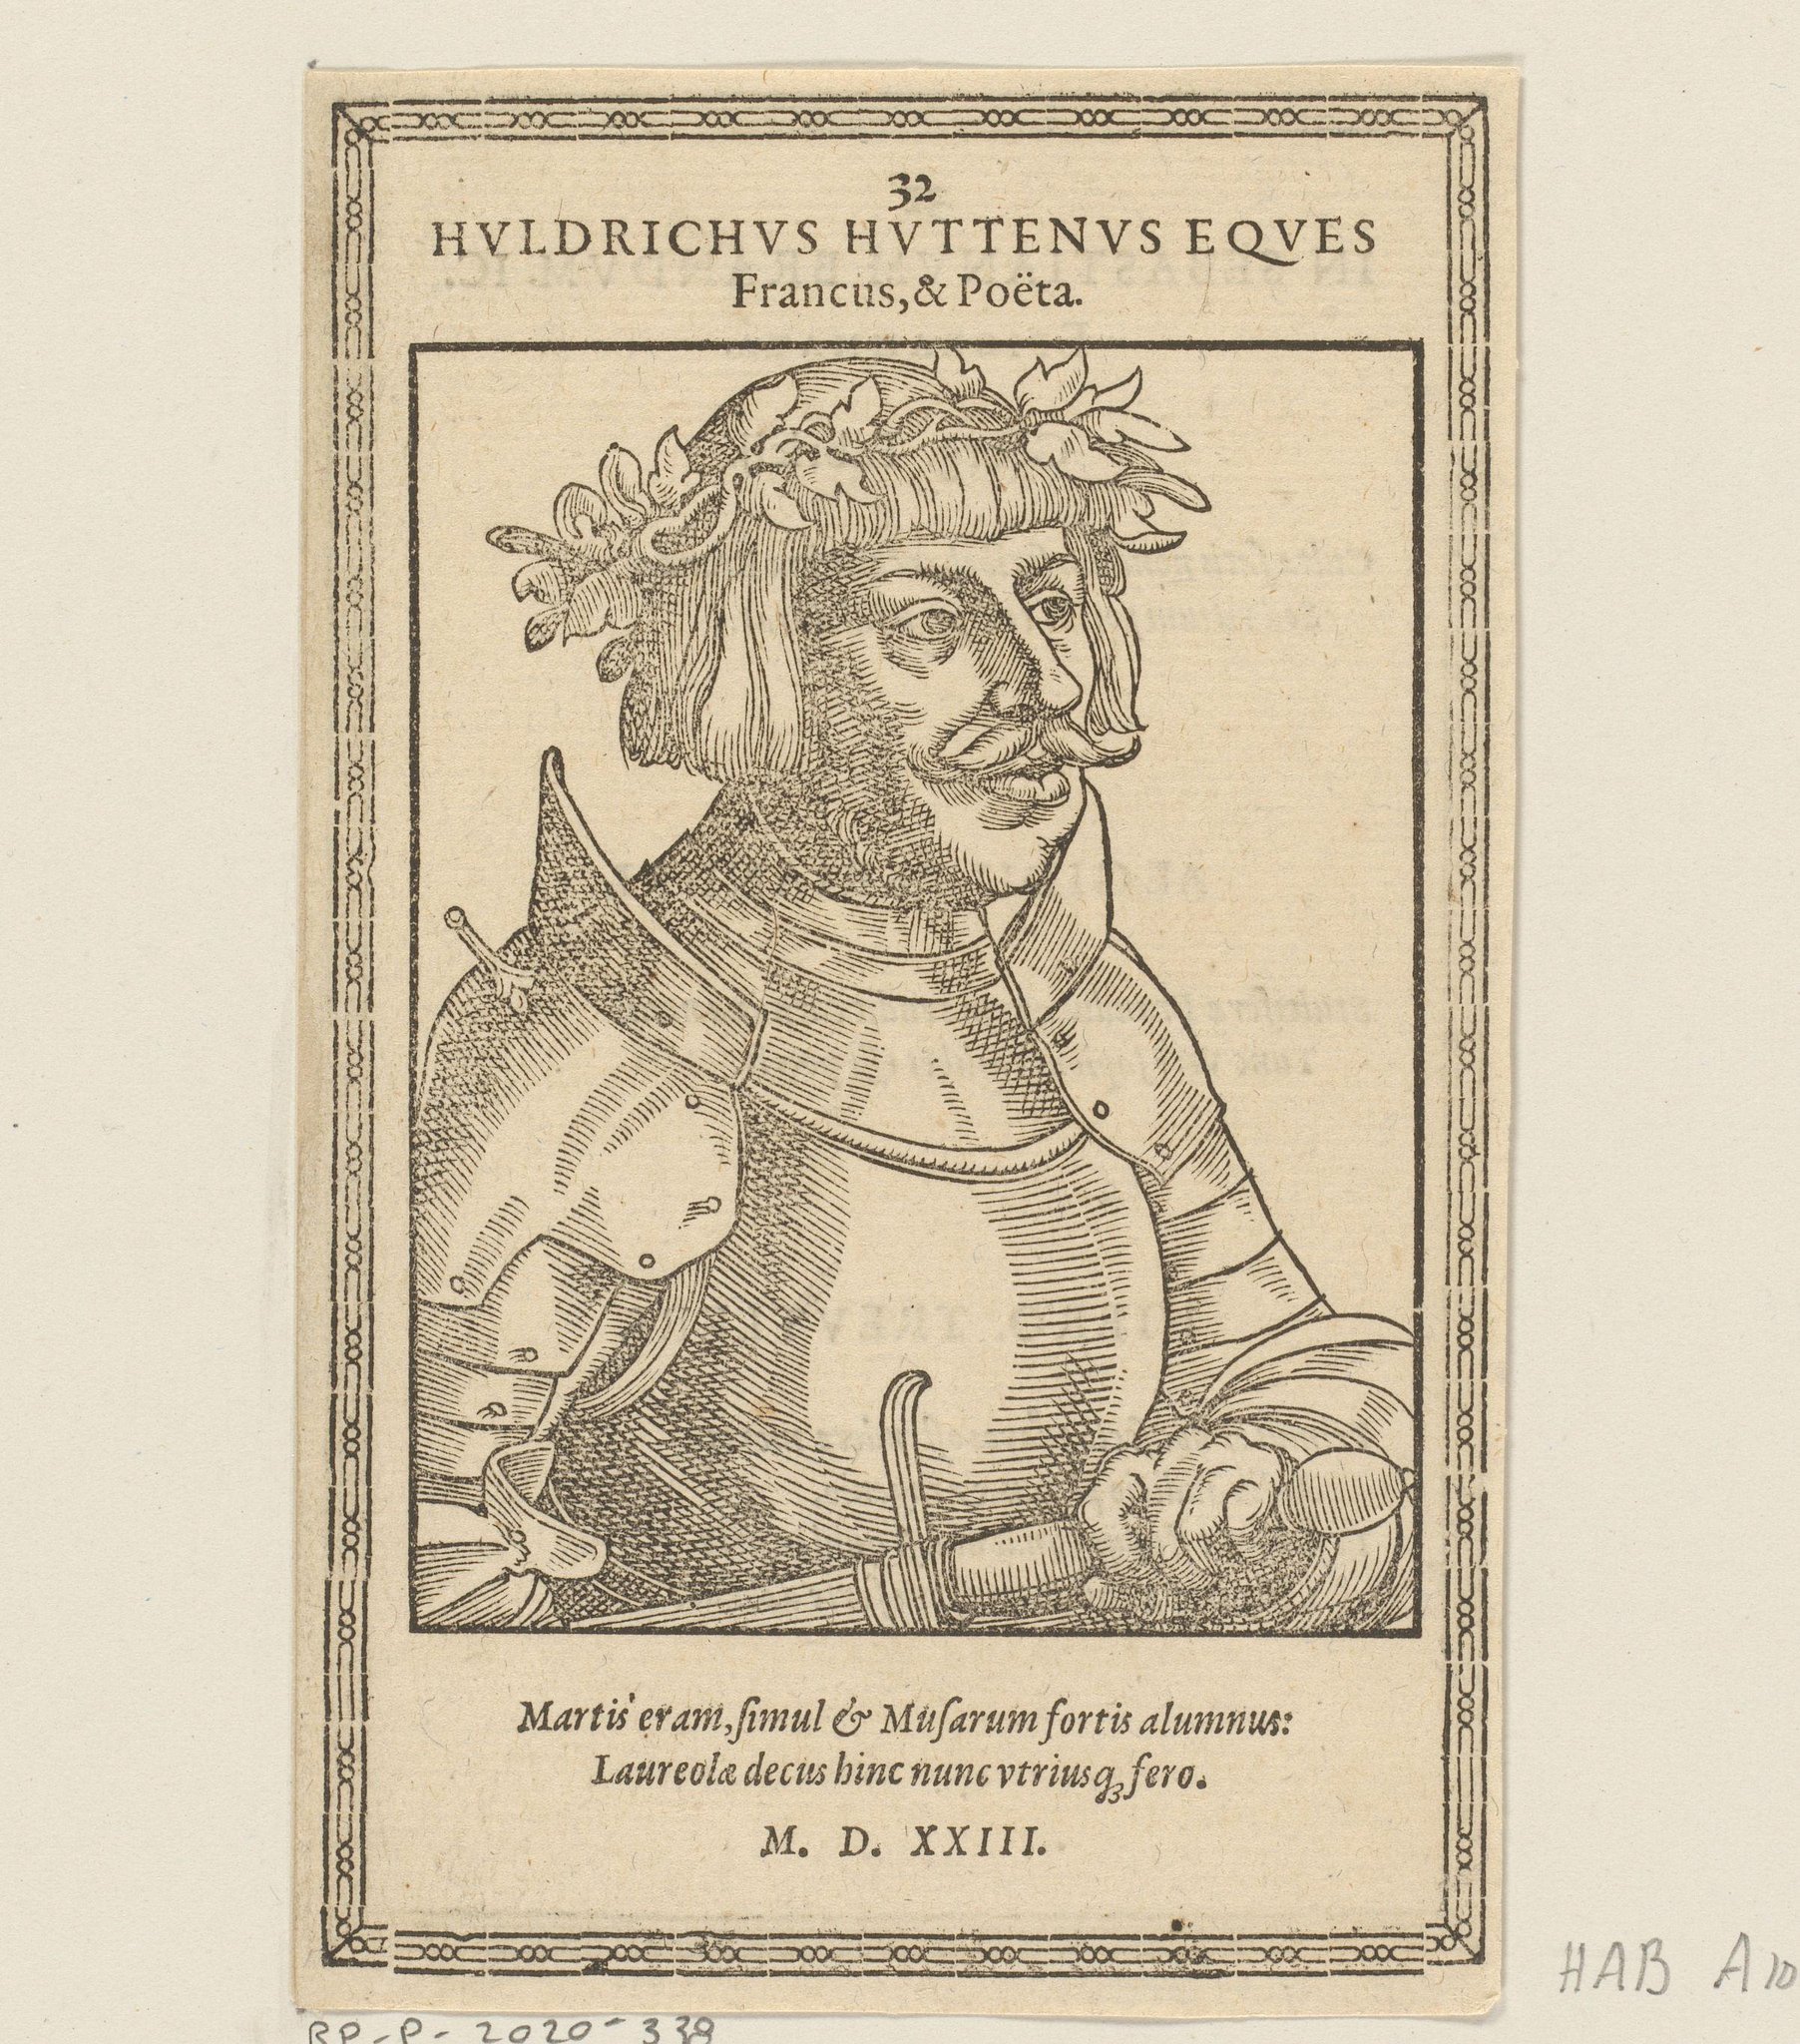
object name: print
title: Portret van Ulrich von Hutten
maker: bernhard jobin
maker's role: printer, publisher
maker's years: 1545-1593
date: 1590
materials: paper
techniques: letterpress printing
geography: straatsburg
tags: switzerland, armour, historical persons, writer, poet, author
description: Prent uit: Reusner, Nikolaus. Icones sive imagines virorum literis illustrium (...). Straatsburg: Bernhard Jobin, 1590, p. 368. Prent voor het eerst verschenen in de eerste editie van 1587. Prent ook gebruikt in latere publicaties.